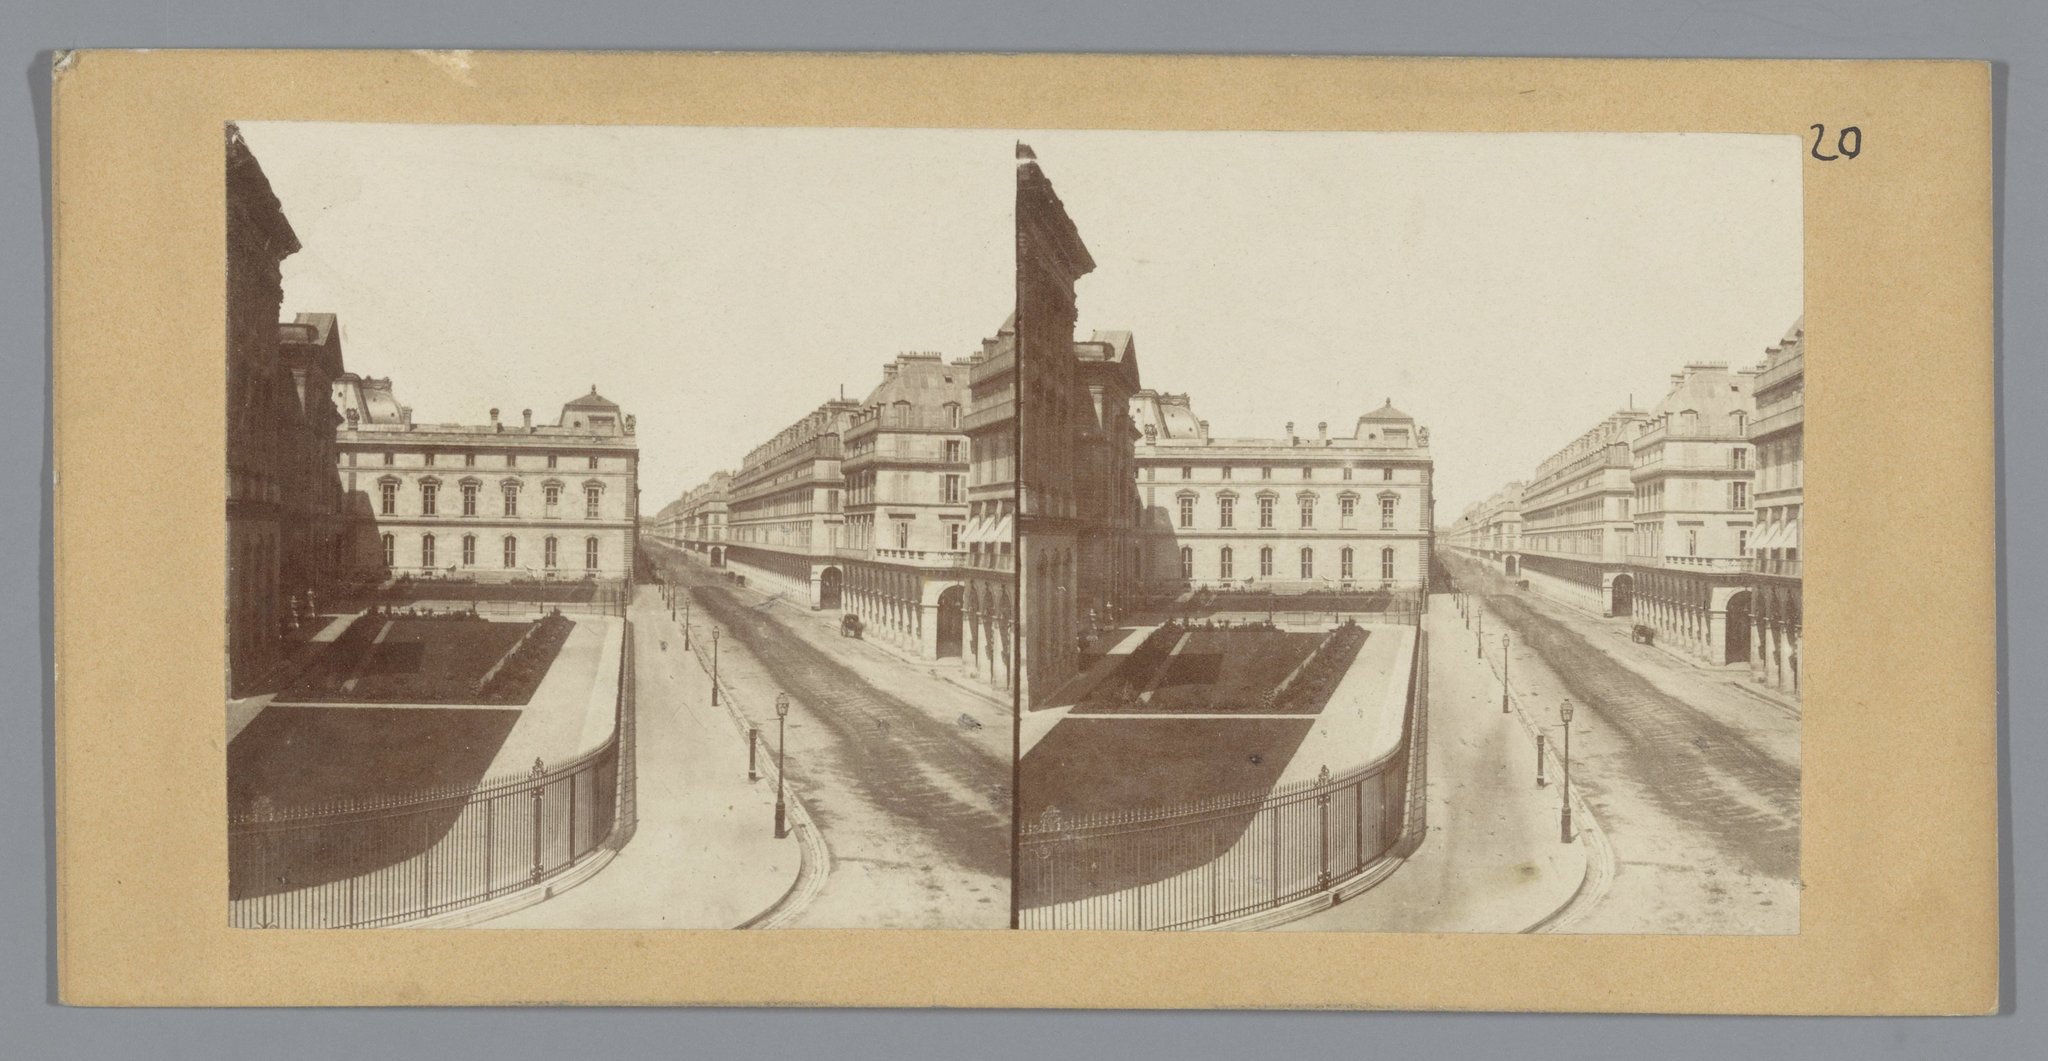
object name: stereograph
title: La Rue de Rivoli, prise des jardins du Louvre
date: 1851-1870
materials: cardboard, paper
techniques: albumen print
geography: paris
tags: street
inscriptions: retailer's mark: ‘222, rue de Rivoli/ en face le Jardin des Tuileries./ Lecocq-Frêne/ Estampes Photographies/ Plans et Guides pour Voyageurs/ Vues pr Stéreoscopes.’, number: ‘20’